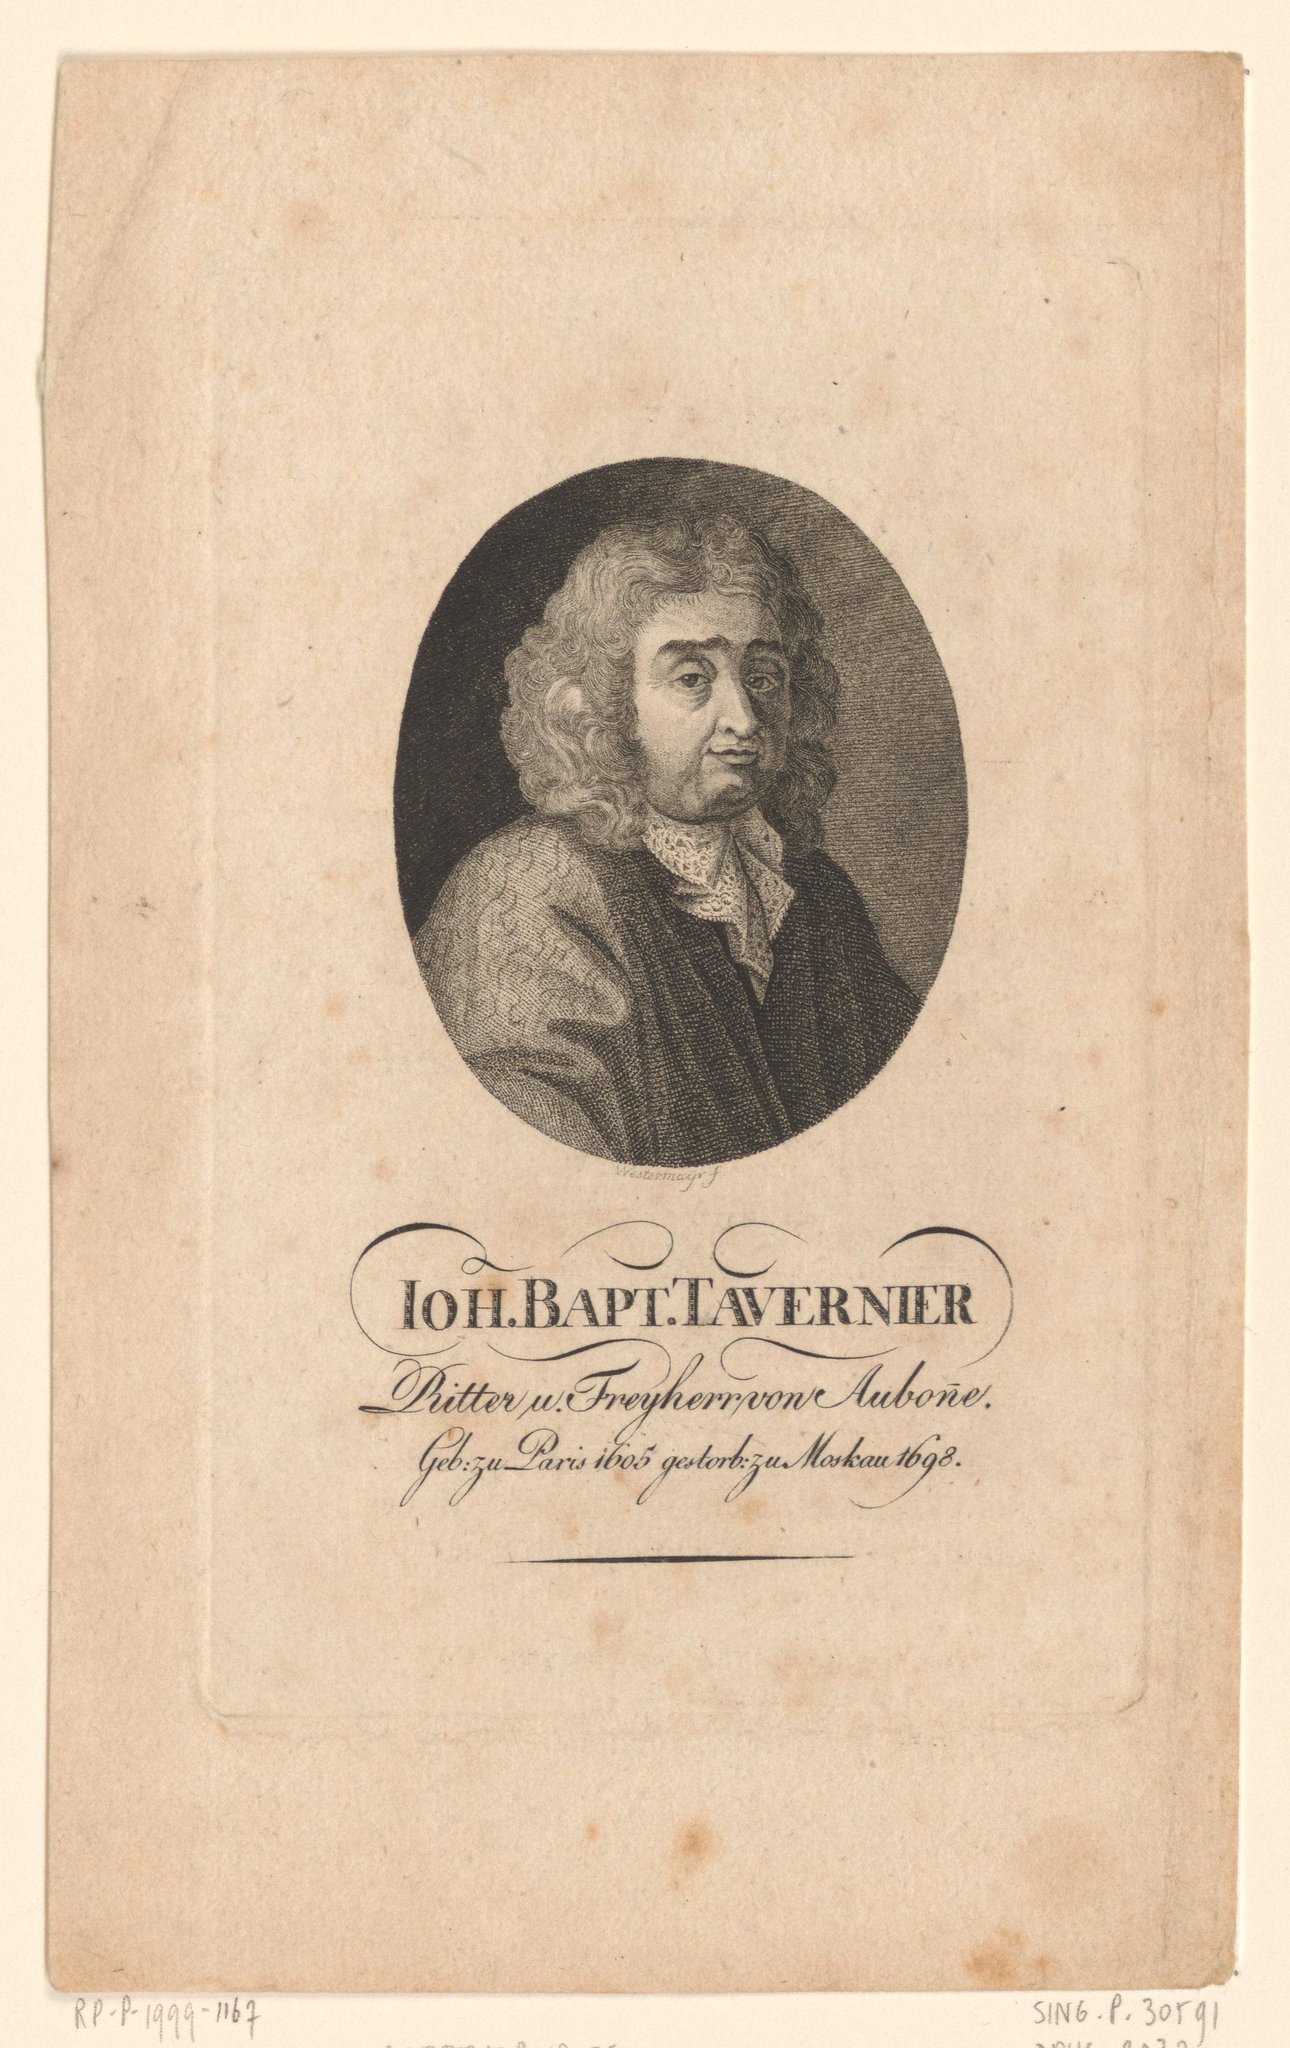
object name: print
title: Portret van Jean-Baptiste Tavernier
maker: konrad westermayr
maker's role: print maker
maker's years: 1765-1834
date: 1775-1834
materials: paper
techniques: engraving, etching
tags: paris, traveler, historical persons, explorer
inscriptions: collector's mark: Lugt 2228, collector's mark: Lugt 2760